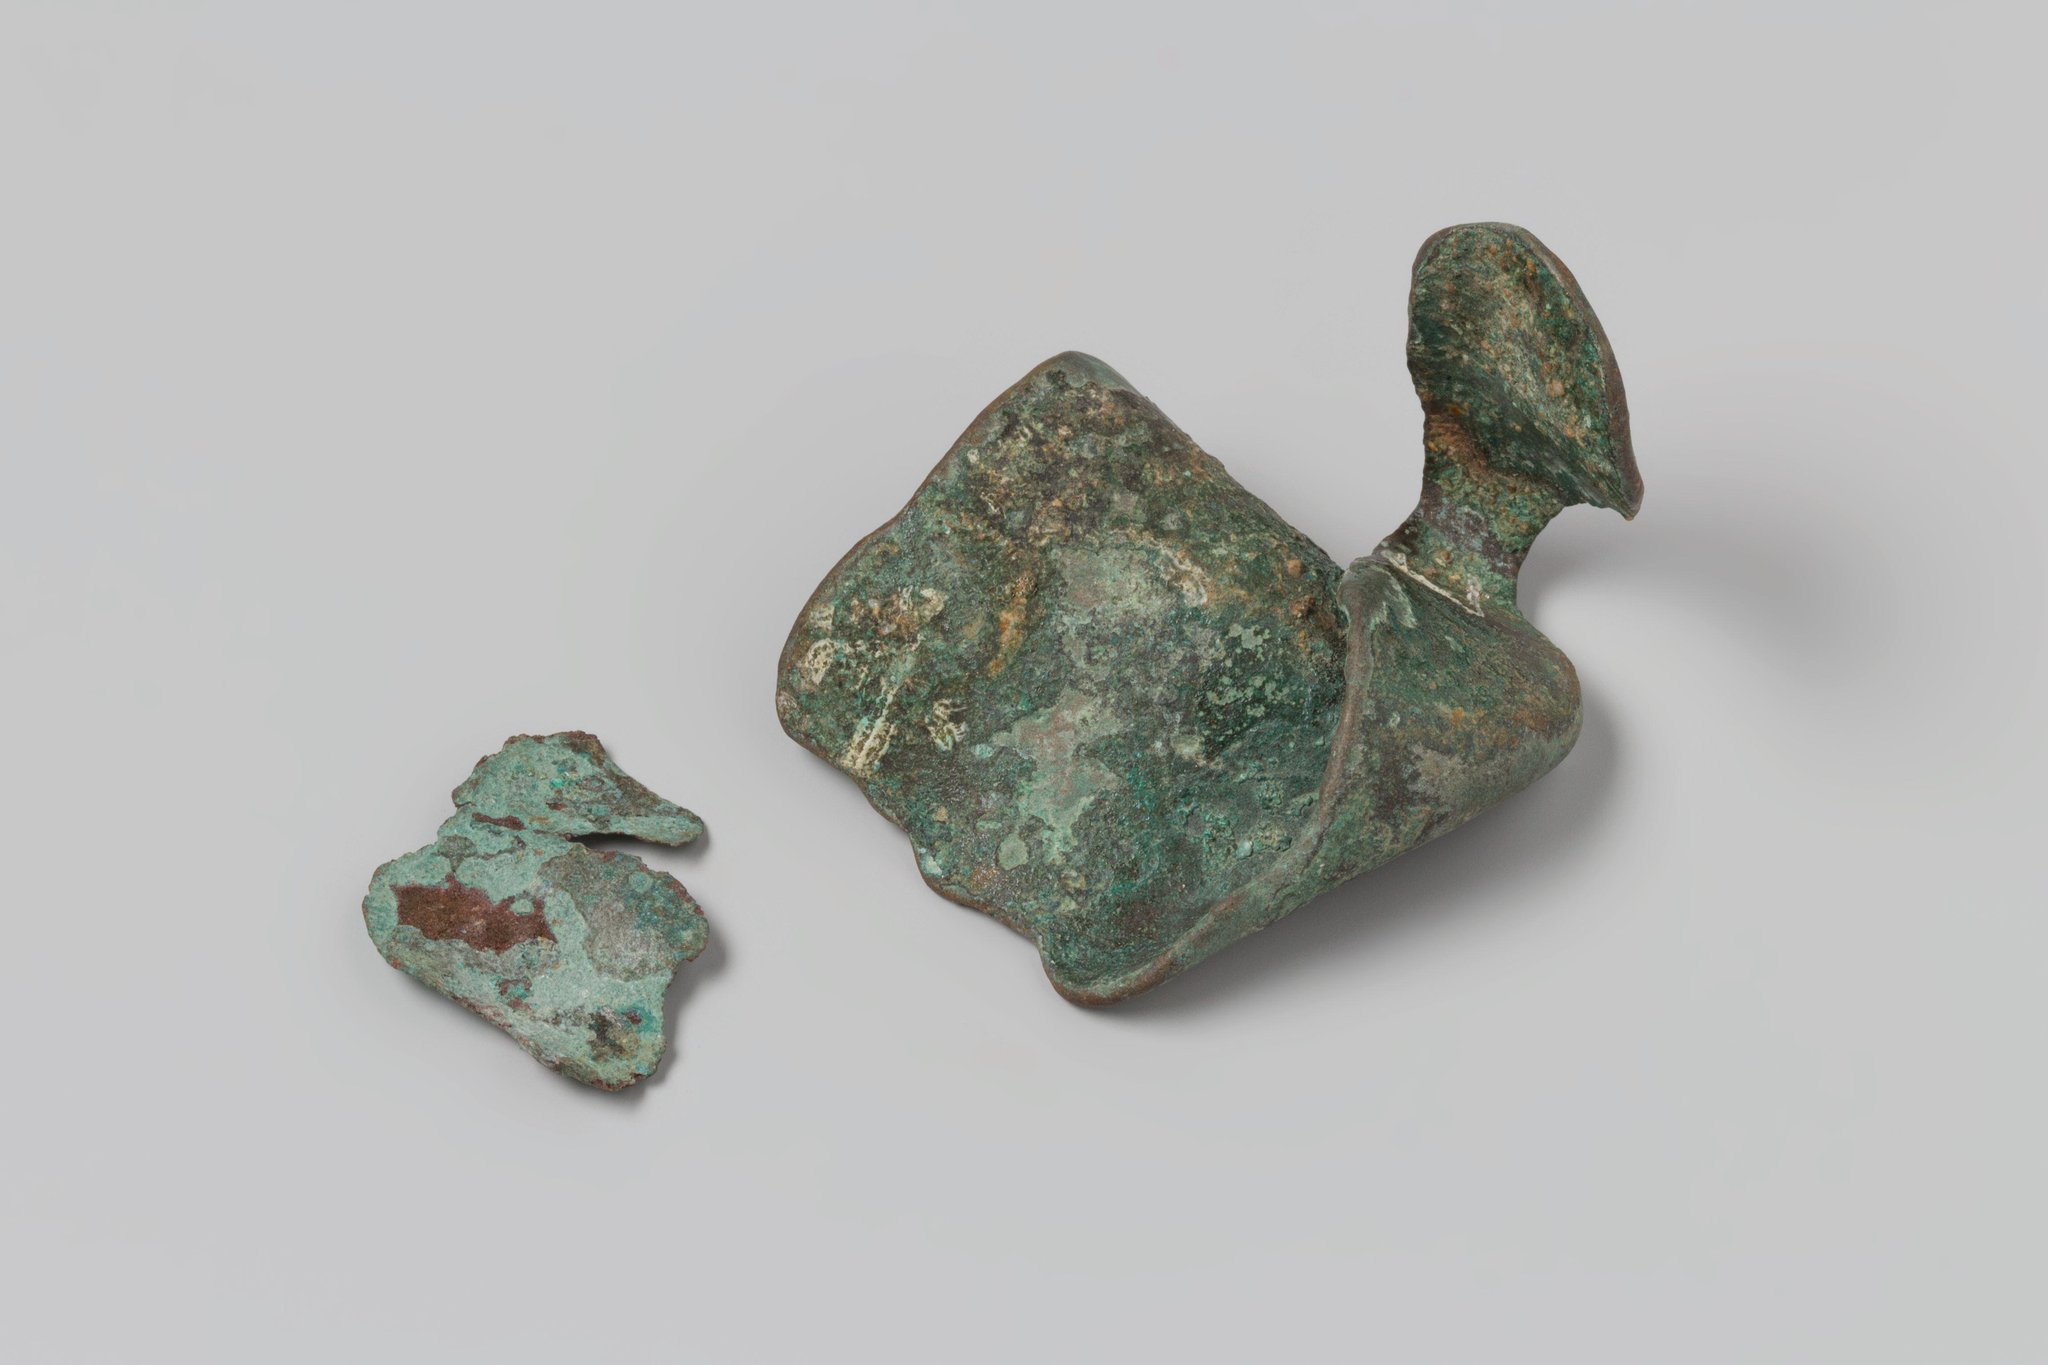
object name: scheepswrakvondst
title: Fragmenten van koper uit het wrak van de Oost-Indiëvaarder Hollandia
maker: Anonymous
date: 1700-1743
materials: copper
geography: netherlands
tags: verenigde oostindische compagnie, hollandia (schip), annet